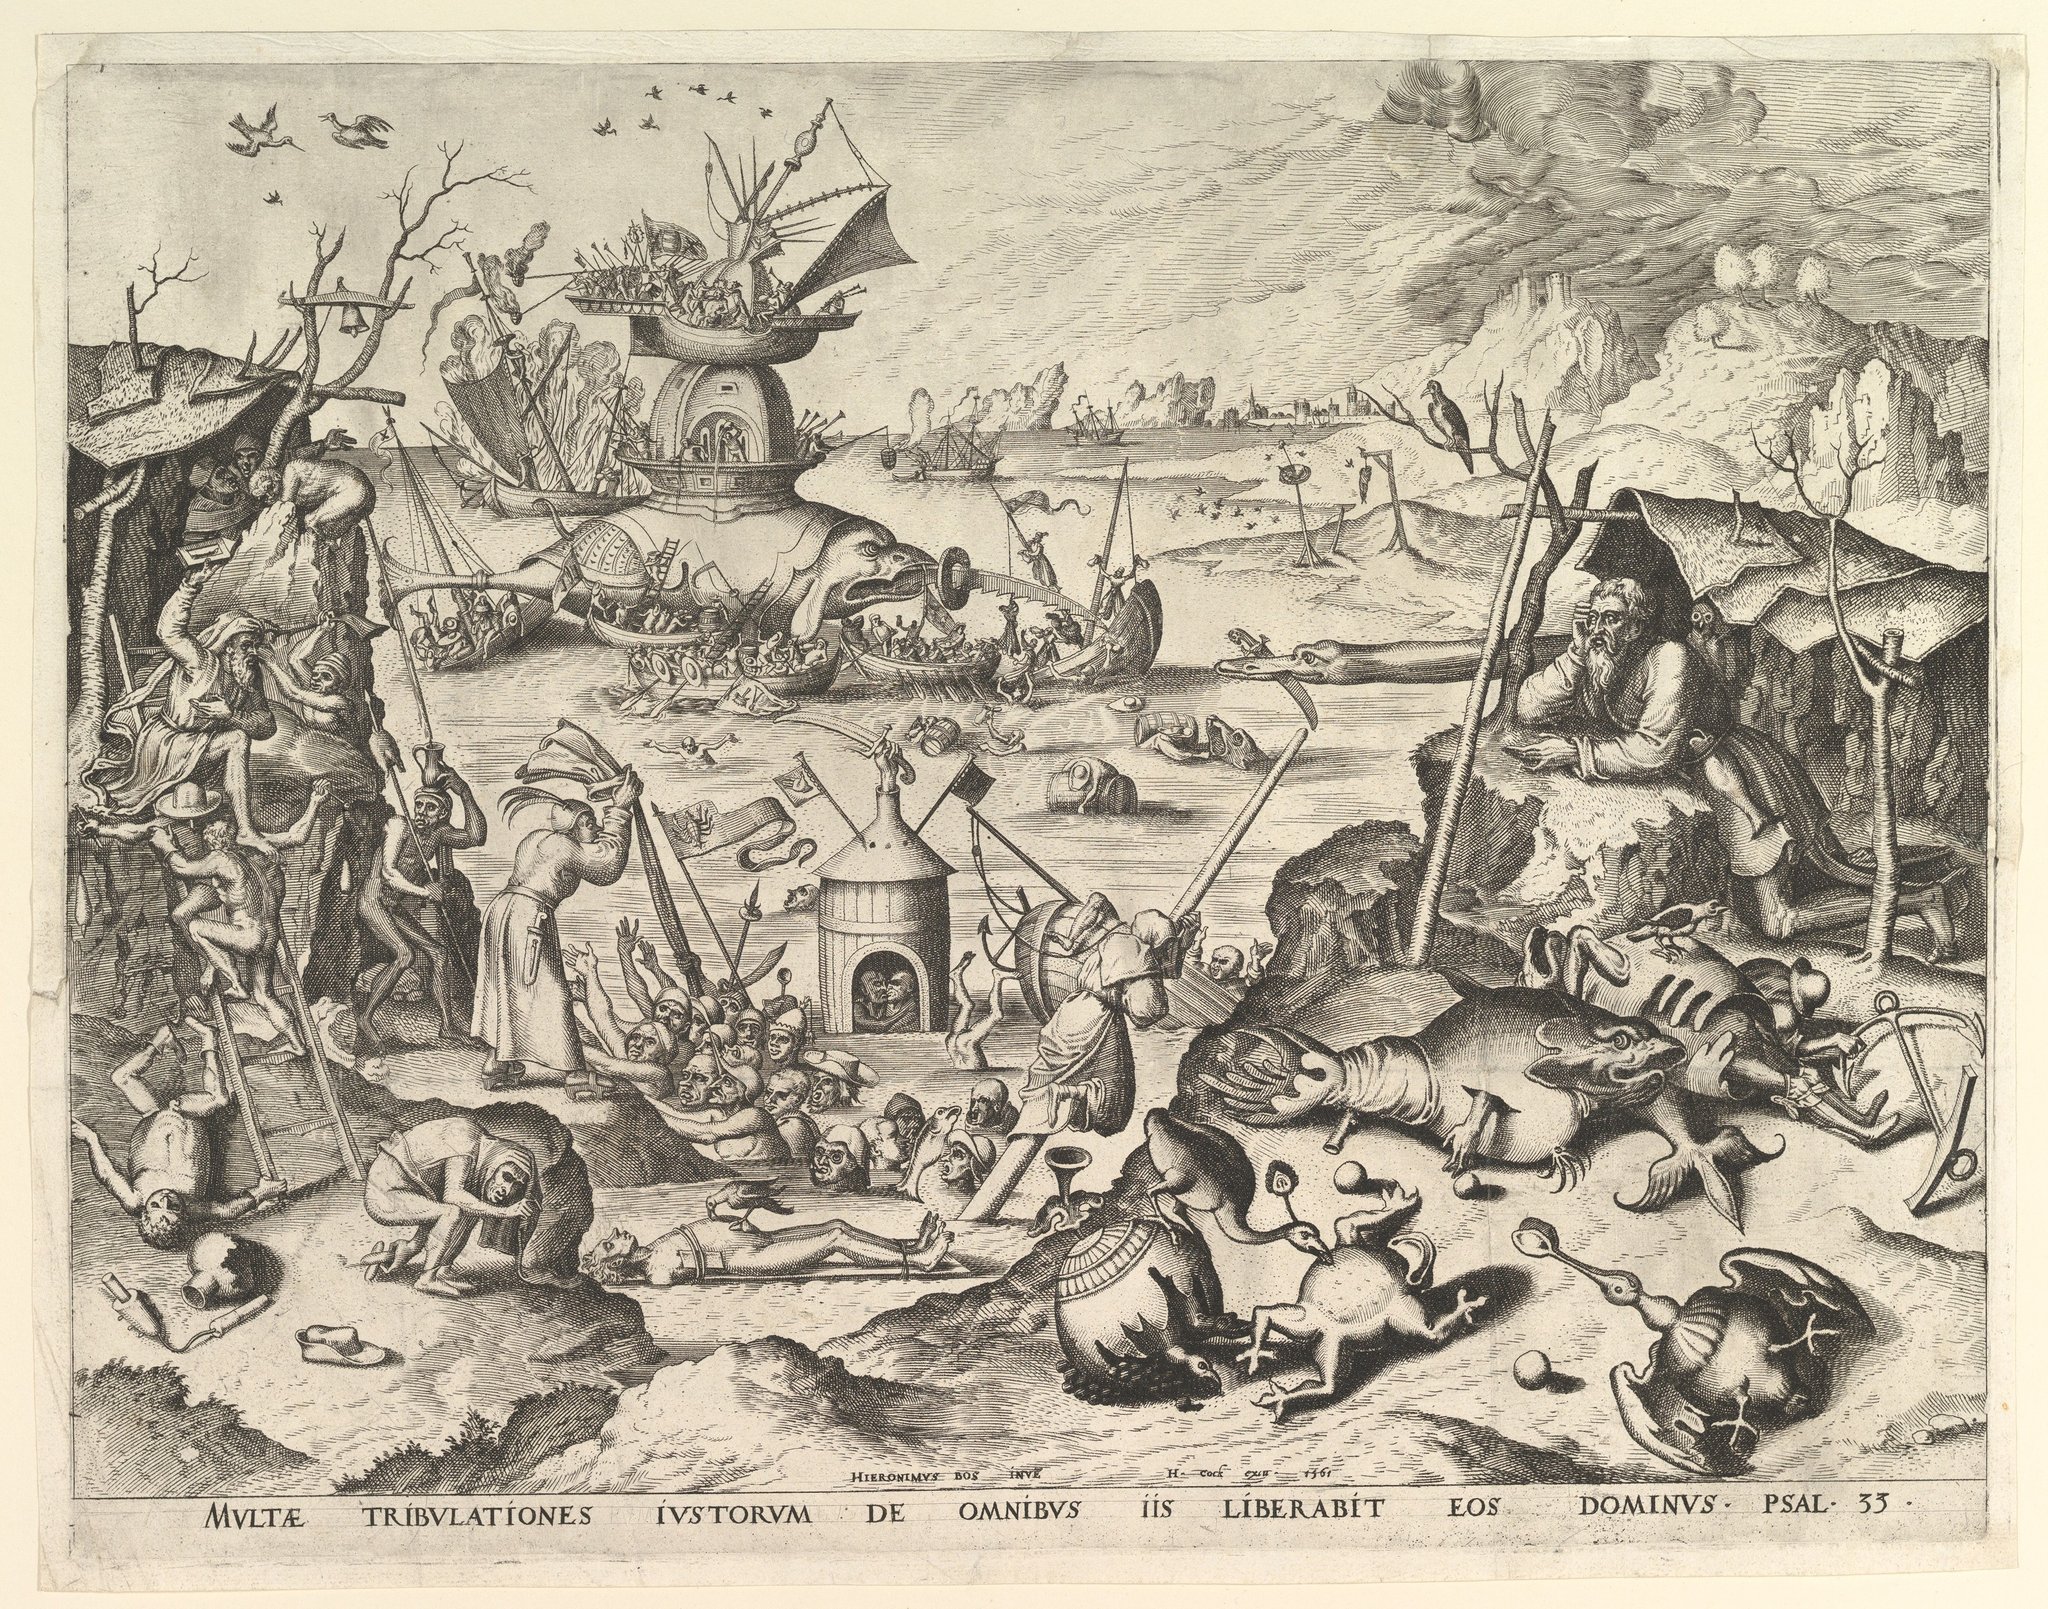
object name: print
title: The Temptation of St. Anthony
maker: hieronymus bosch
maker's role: artist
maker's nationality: netherlandish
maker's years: 1450-1516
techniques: etching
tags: birds,men,saint anthony,boats